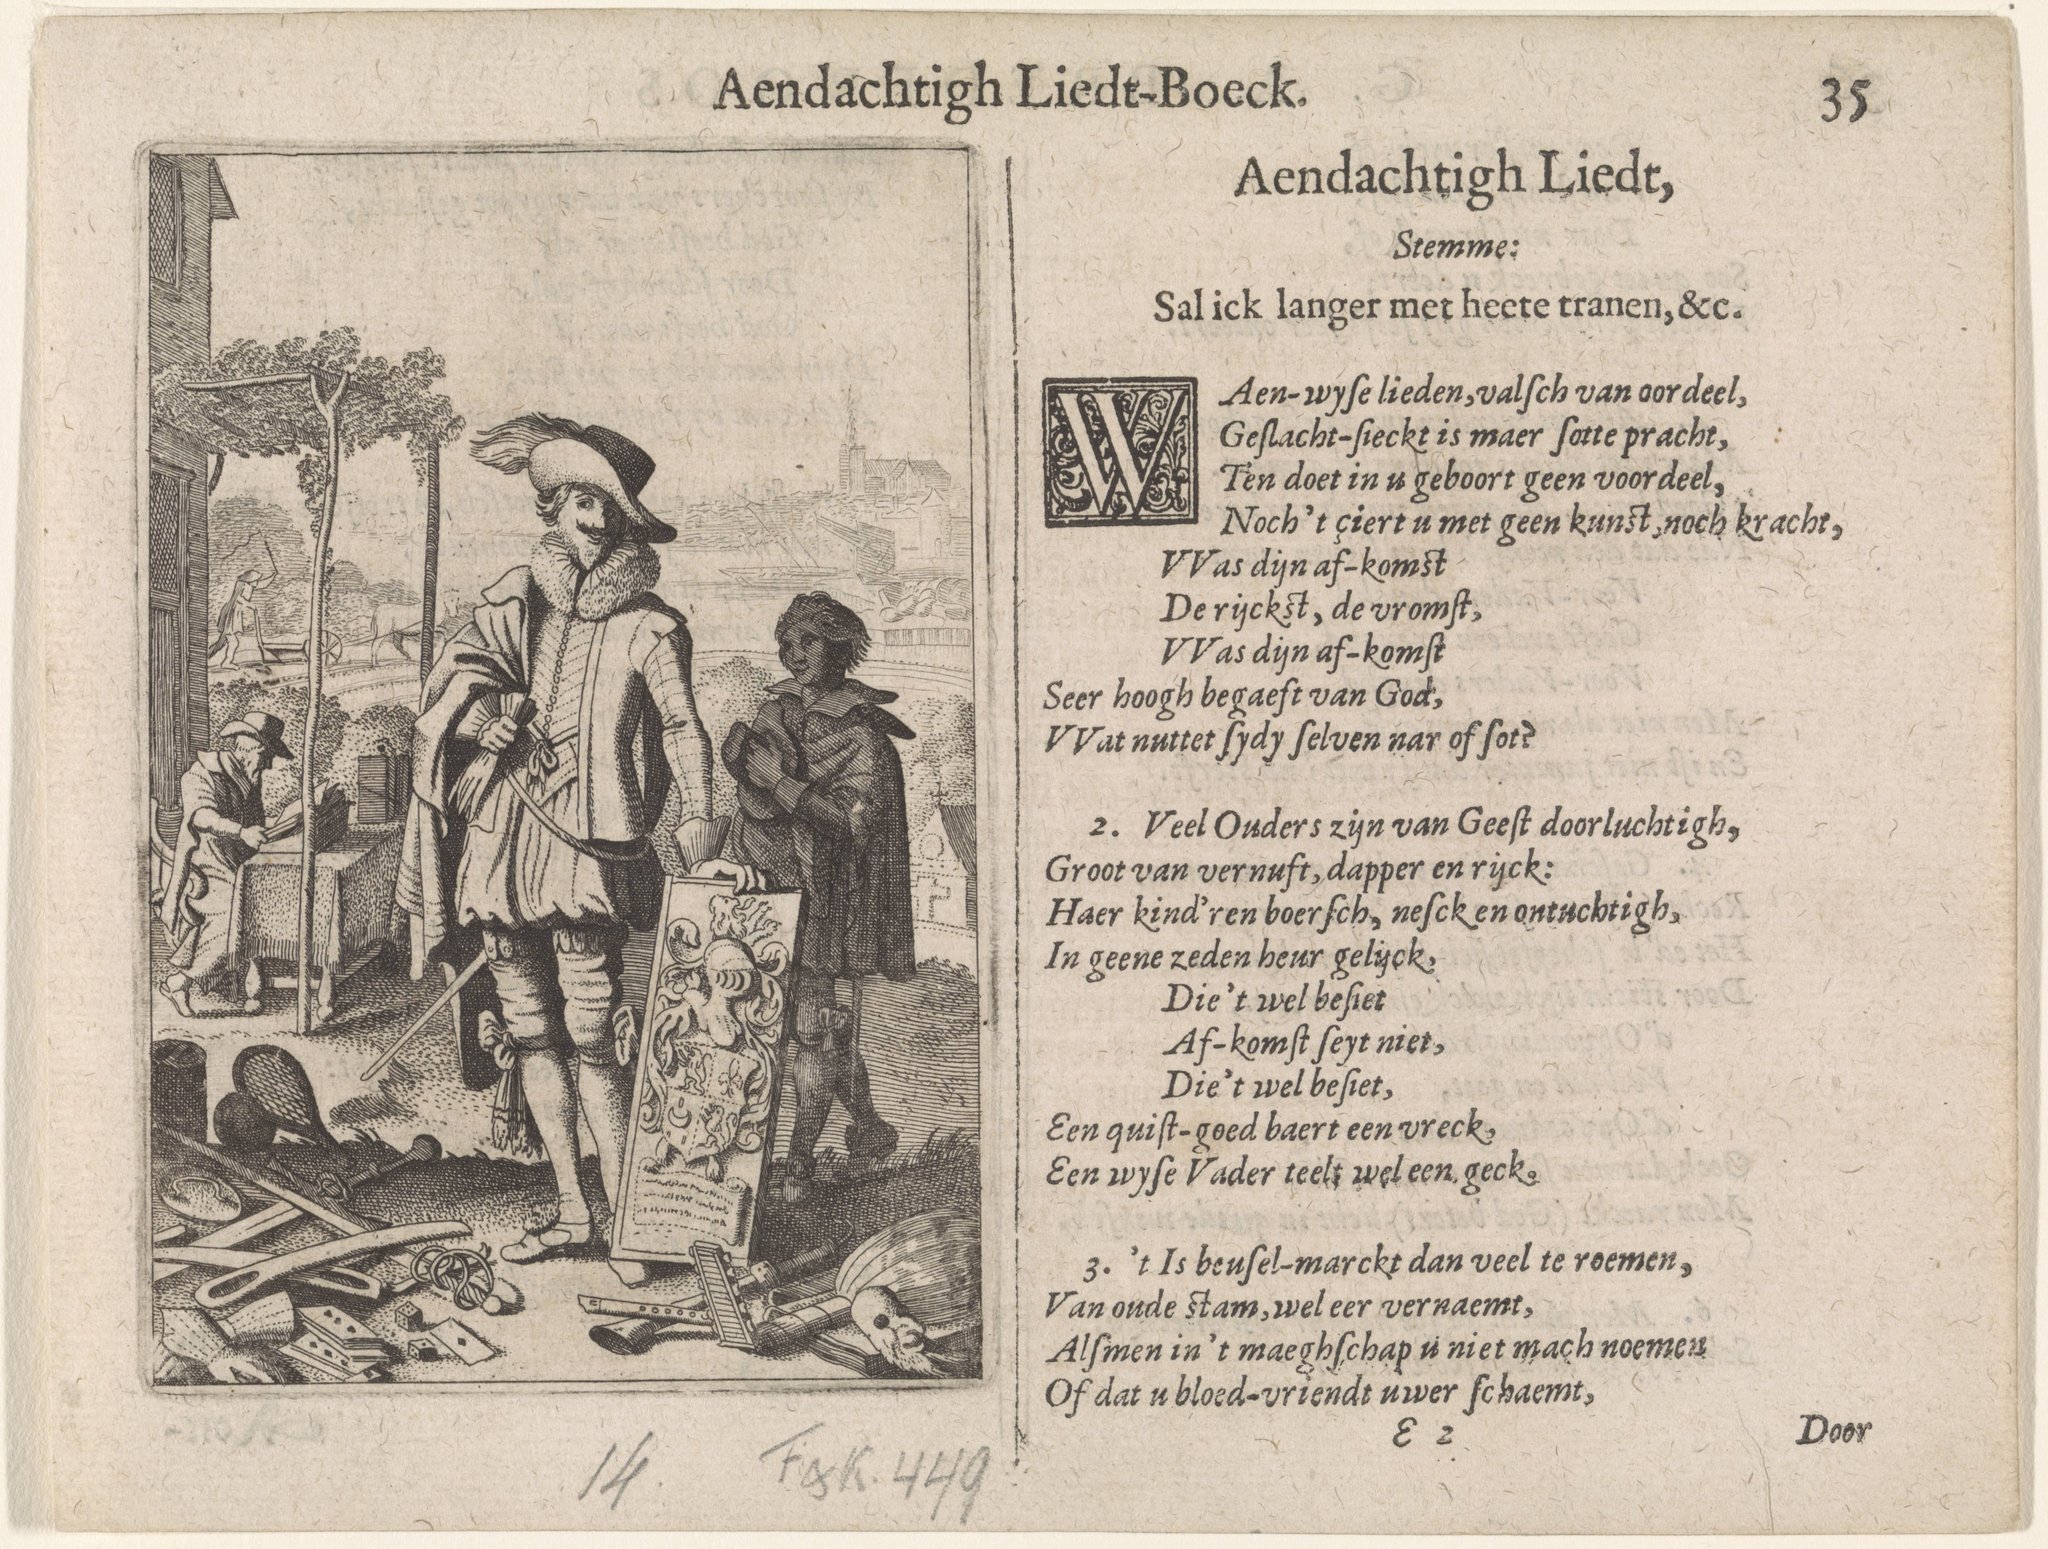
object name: print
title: Pronklustige edelman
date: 1622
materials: paper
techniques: etching, letterpress printing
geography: amsterdam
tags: group games, party games (+ requirements, necessaries ~ sports and games), exhibition of wealth, education, ploughing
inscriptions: collector's mark: Lugt 964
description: Een elegant geklede man met zijn hand rustend op een faimiliewapen. Achter hem een jongere man met zijn hoed in de hand. Voor hem op de grond liggen voorwerpen die verwijzen naar ijdelheid en wereldlijkheden zoals speelkaarten, tennisracket, dobbelstenen, handschoenen, muziekinstrumenten zoals een luit en een fluit, en een masker. Op de achtergrond een studerende man en een ploegende boer. Boekillustratie uit G.A. Bredero, Boertigh, amoreus, en aendachtigh groot lied-boeck, 1622. Rechtsboven paginanummer 35.